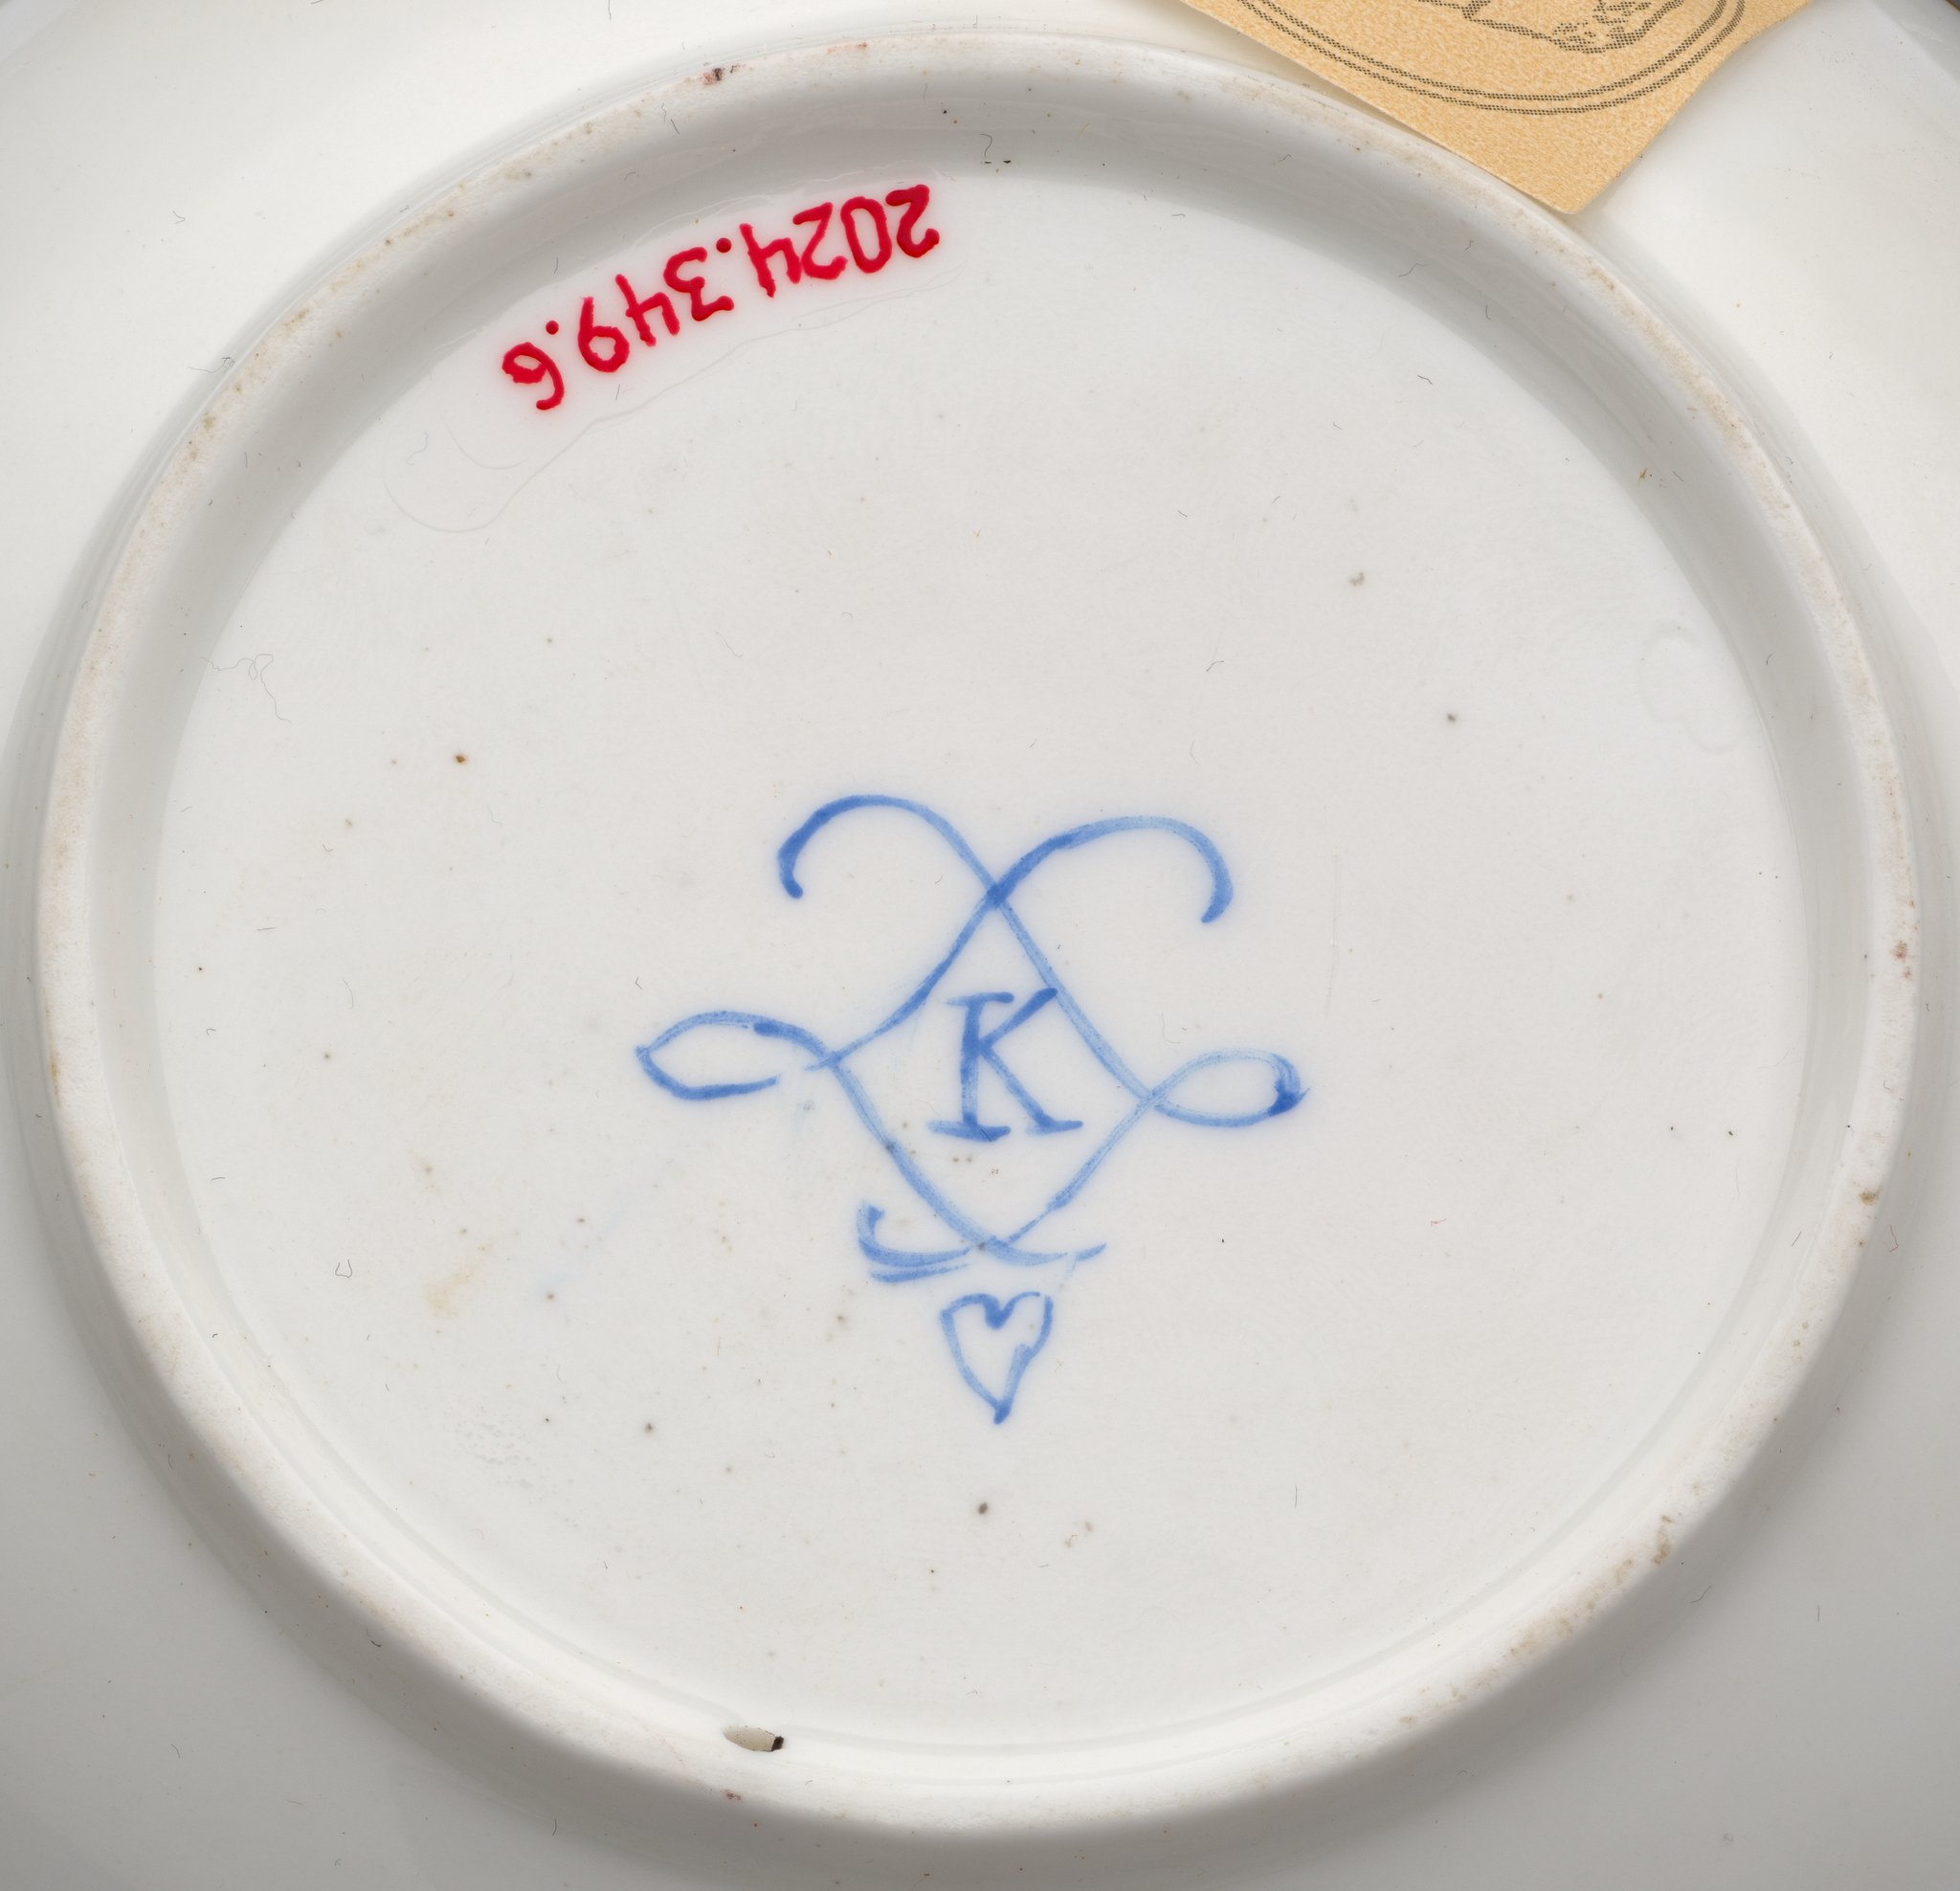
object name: saucer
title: Saucer (soucoupe ‘Bouillard,’ 2eme grandeur) (part of a déjeuner service)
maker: sèvres manufactory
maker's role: maker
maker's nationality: french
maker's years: 1740-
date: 1763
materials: soft paste porcelain